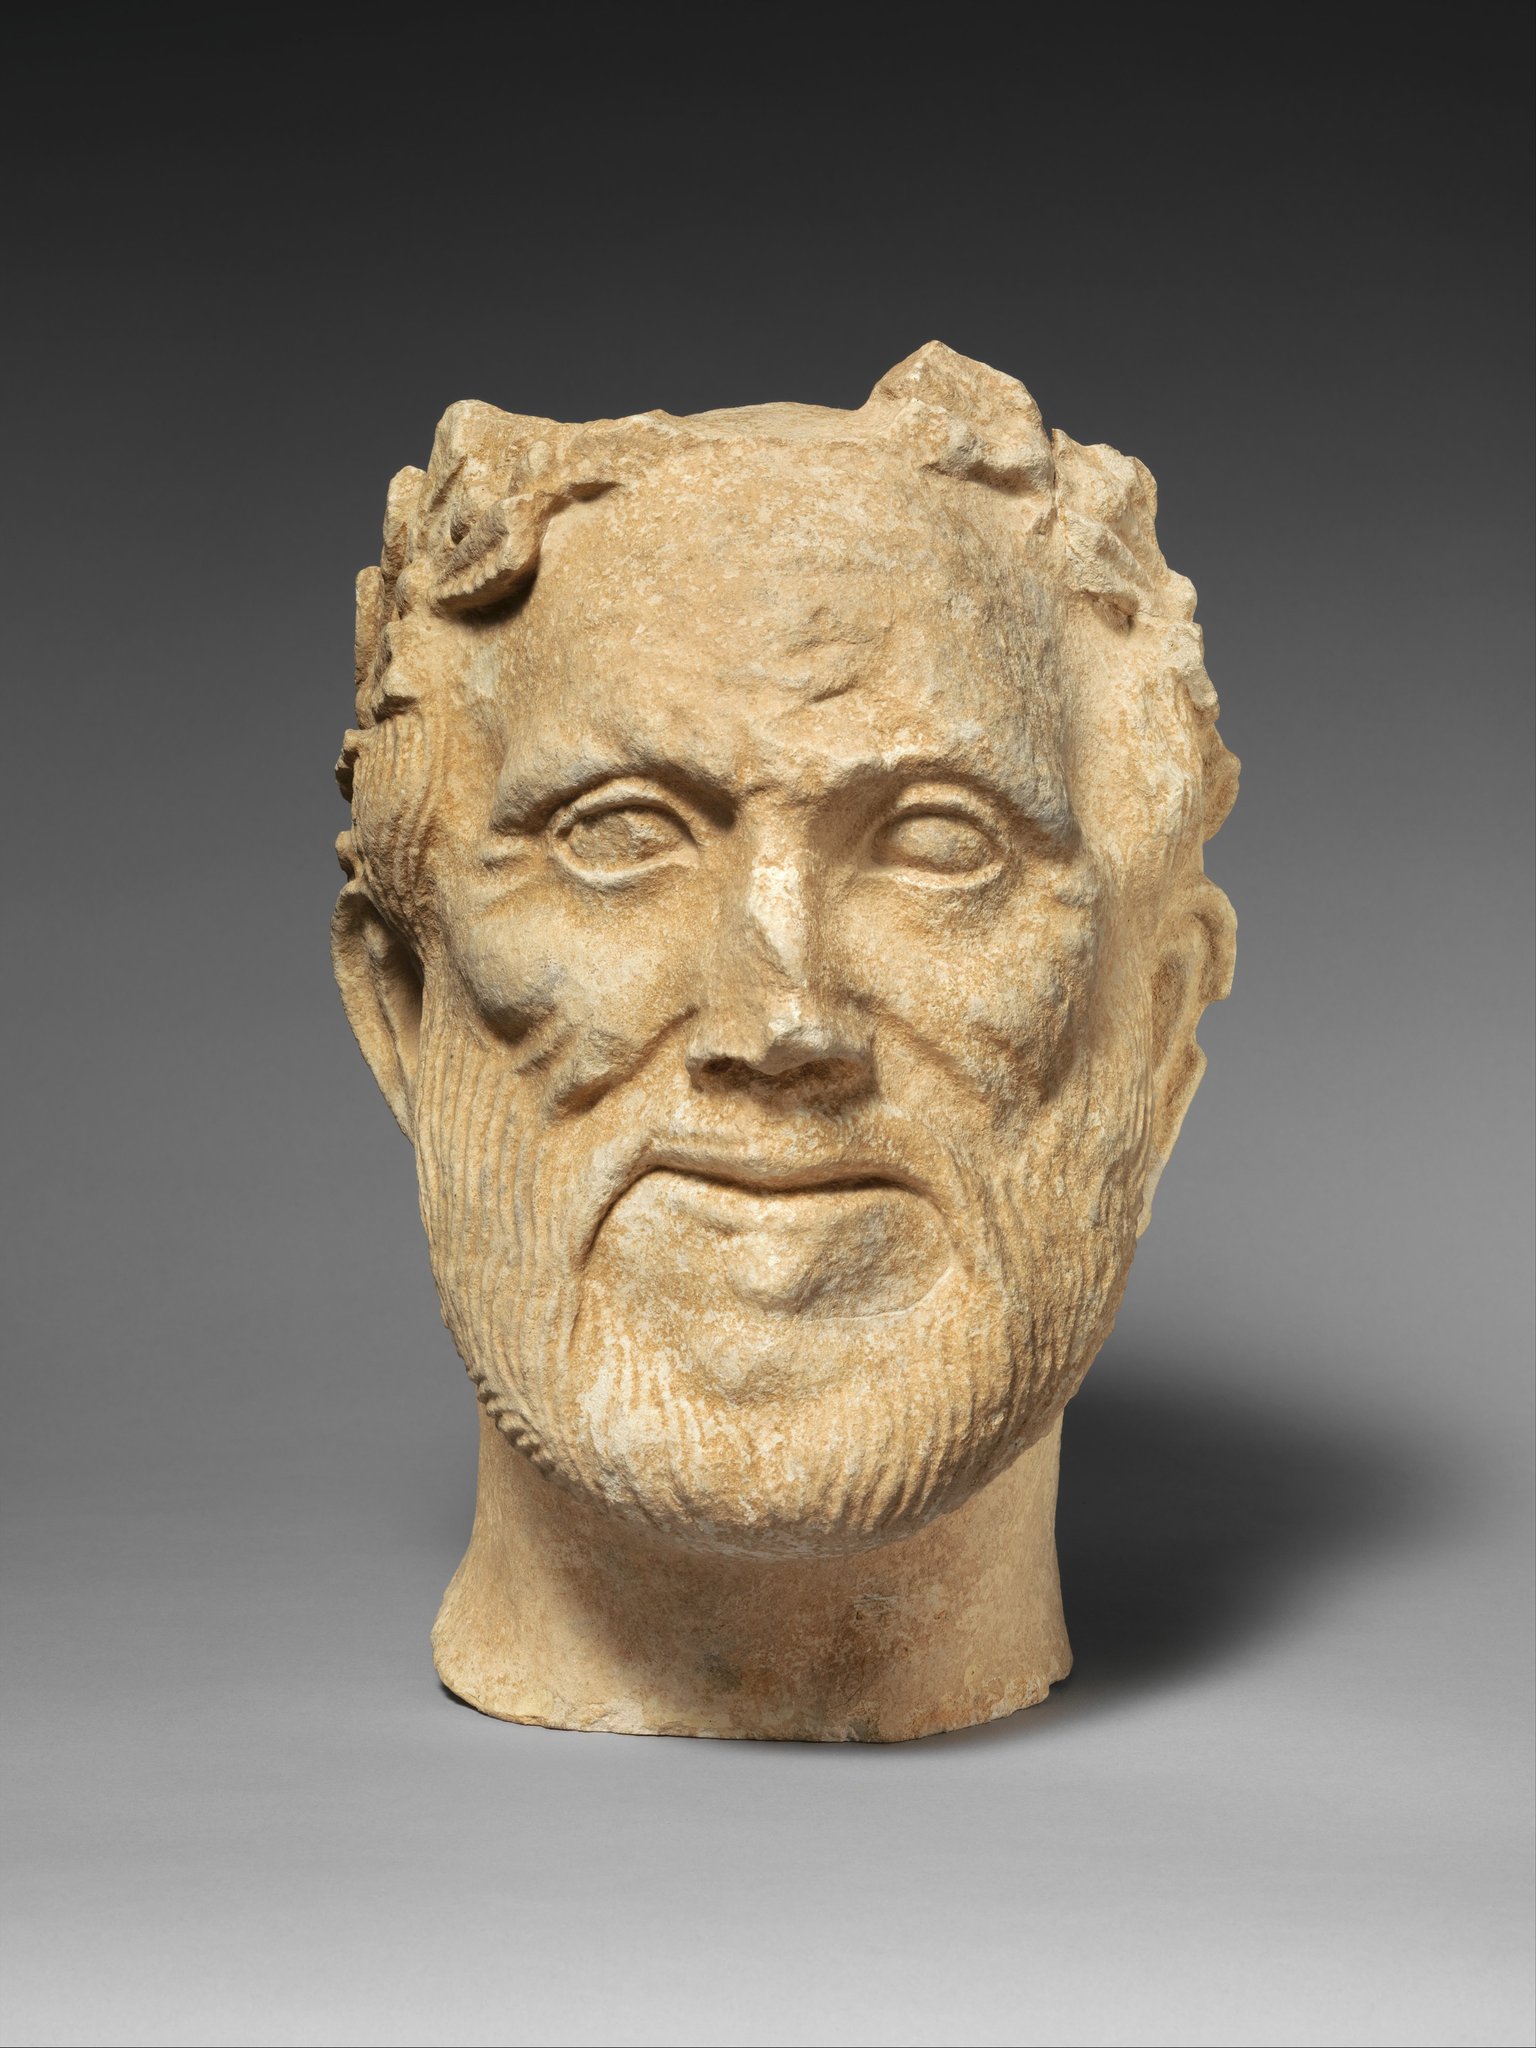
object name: portrait head of an elderly man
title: Limestone head of bearded male votary with wreath of leaves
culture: cypriot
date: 100-1 BCE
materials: limestone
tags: heads,men,leaves,wreaths